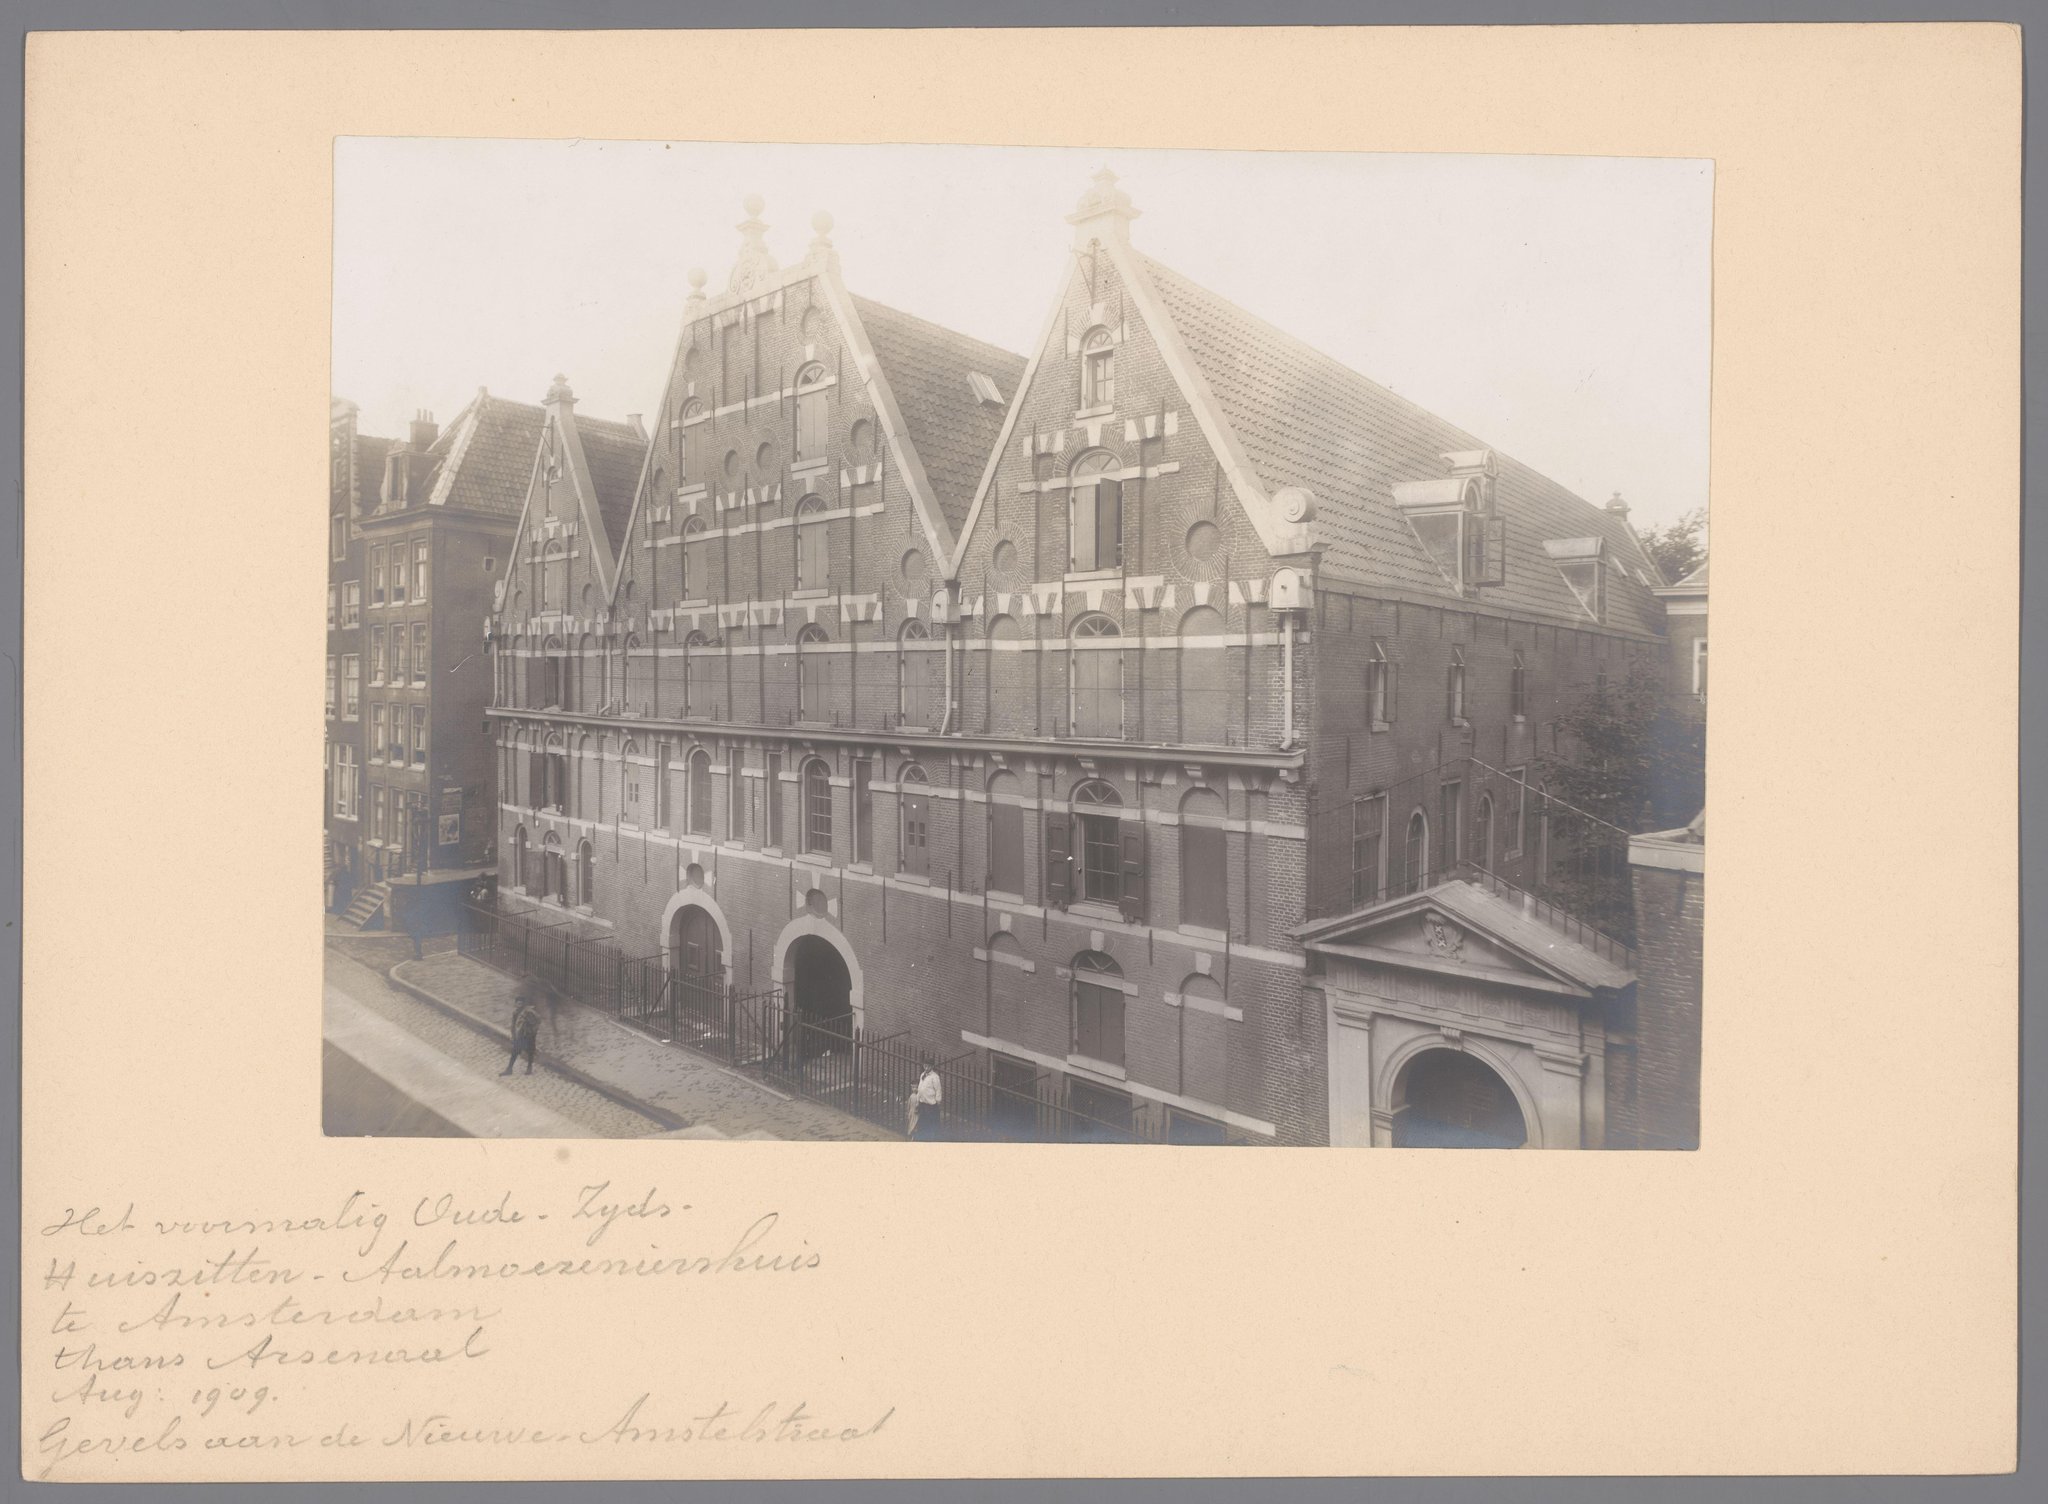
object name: photograph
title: Voorgevel van het Arsenaal of stadsturfpakhuizen te Amsterdam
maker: anoniem (monumentenzorg)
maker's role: fotograaf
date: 1909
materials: cardboard, photographic support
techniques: gelatin silver print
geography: nieuwe amstelstraat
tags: large-scale structure for storage, e.g.: warehouse, depot, silo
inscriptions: annotation: ‘Het voormalig Oude-Zijds-Huiszitten-Aalmoezeniershuis te Amsterdam/ thans Arsenaal/ Aug: 1909/ Gevels aan de Nieuwe Amstelstraat’